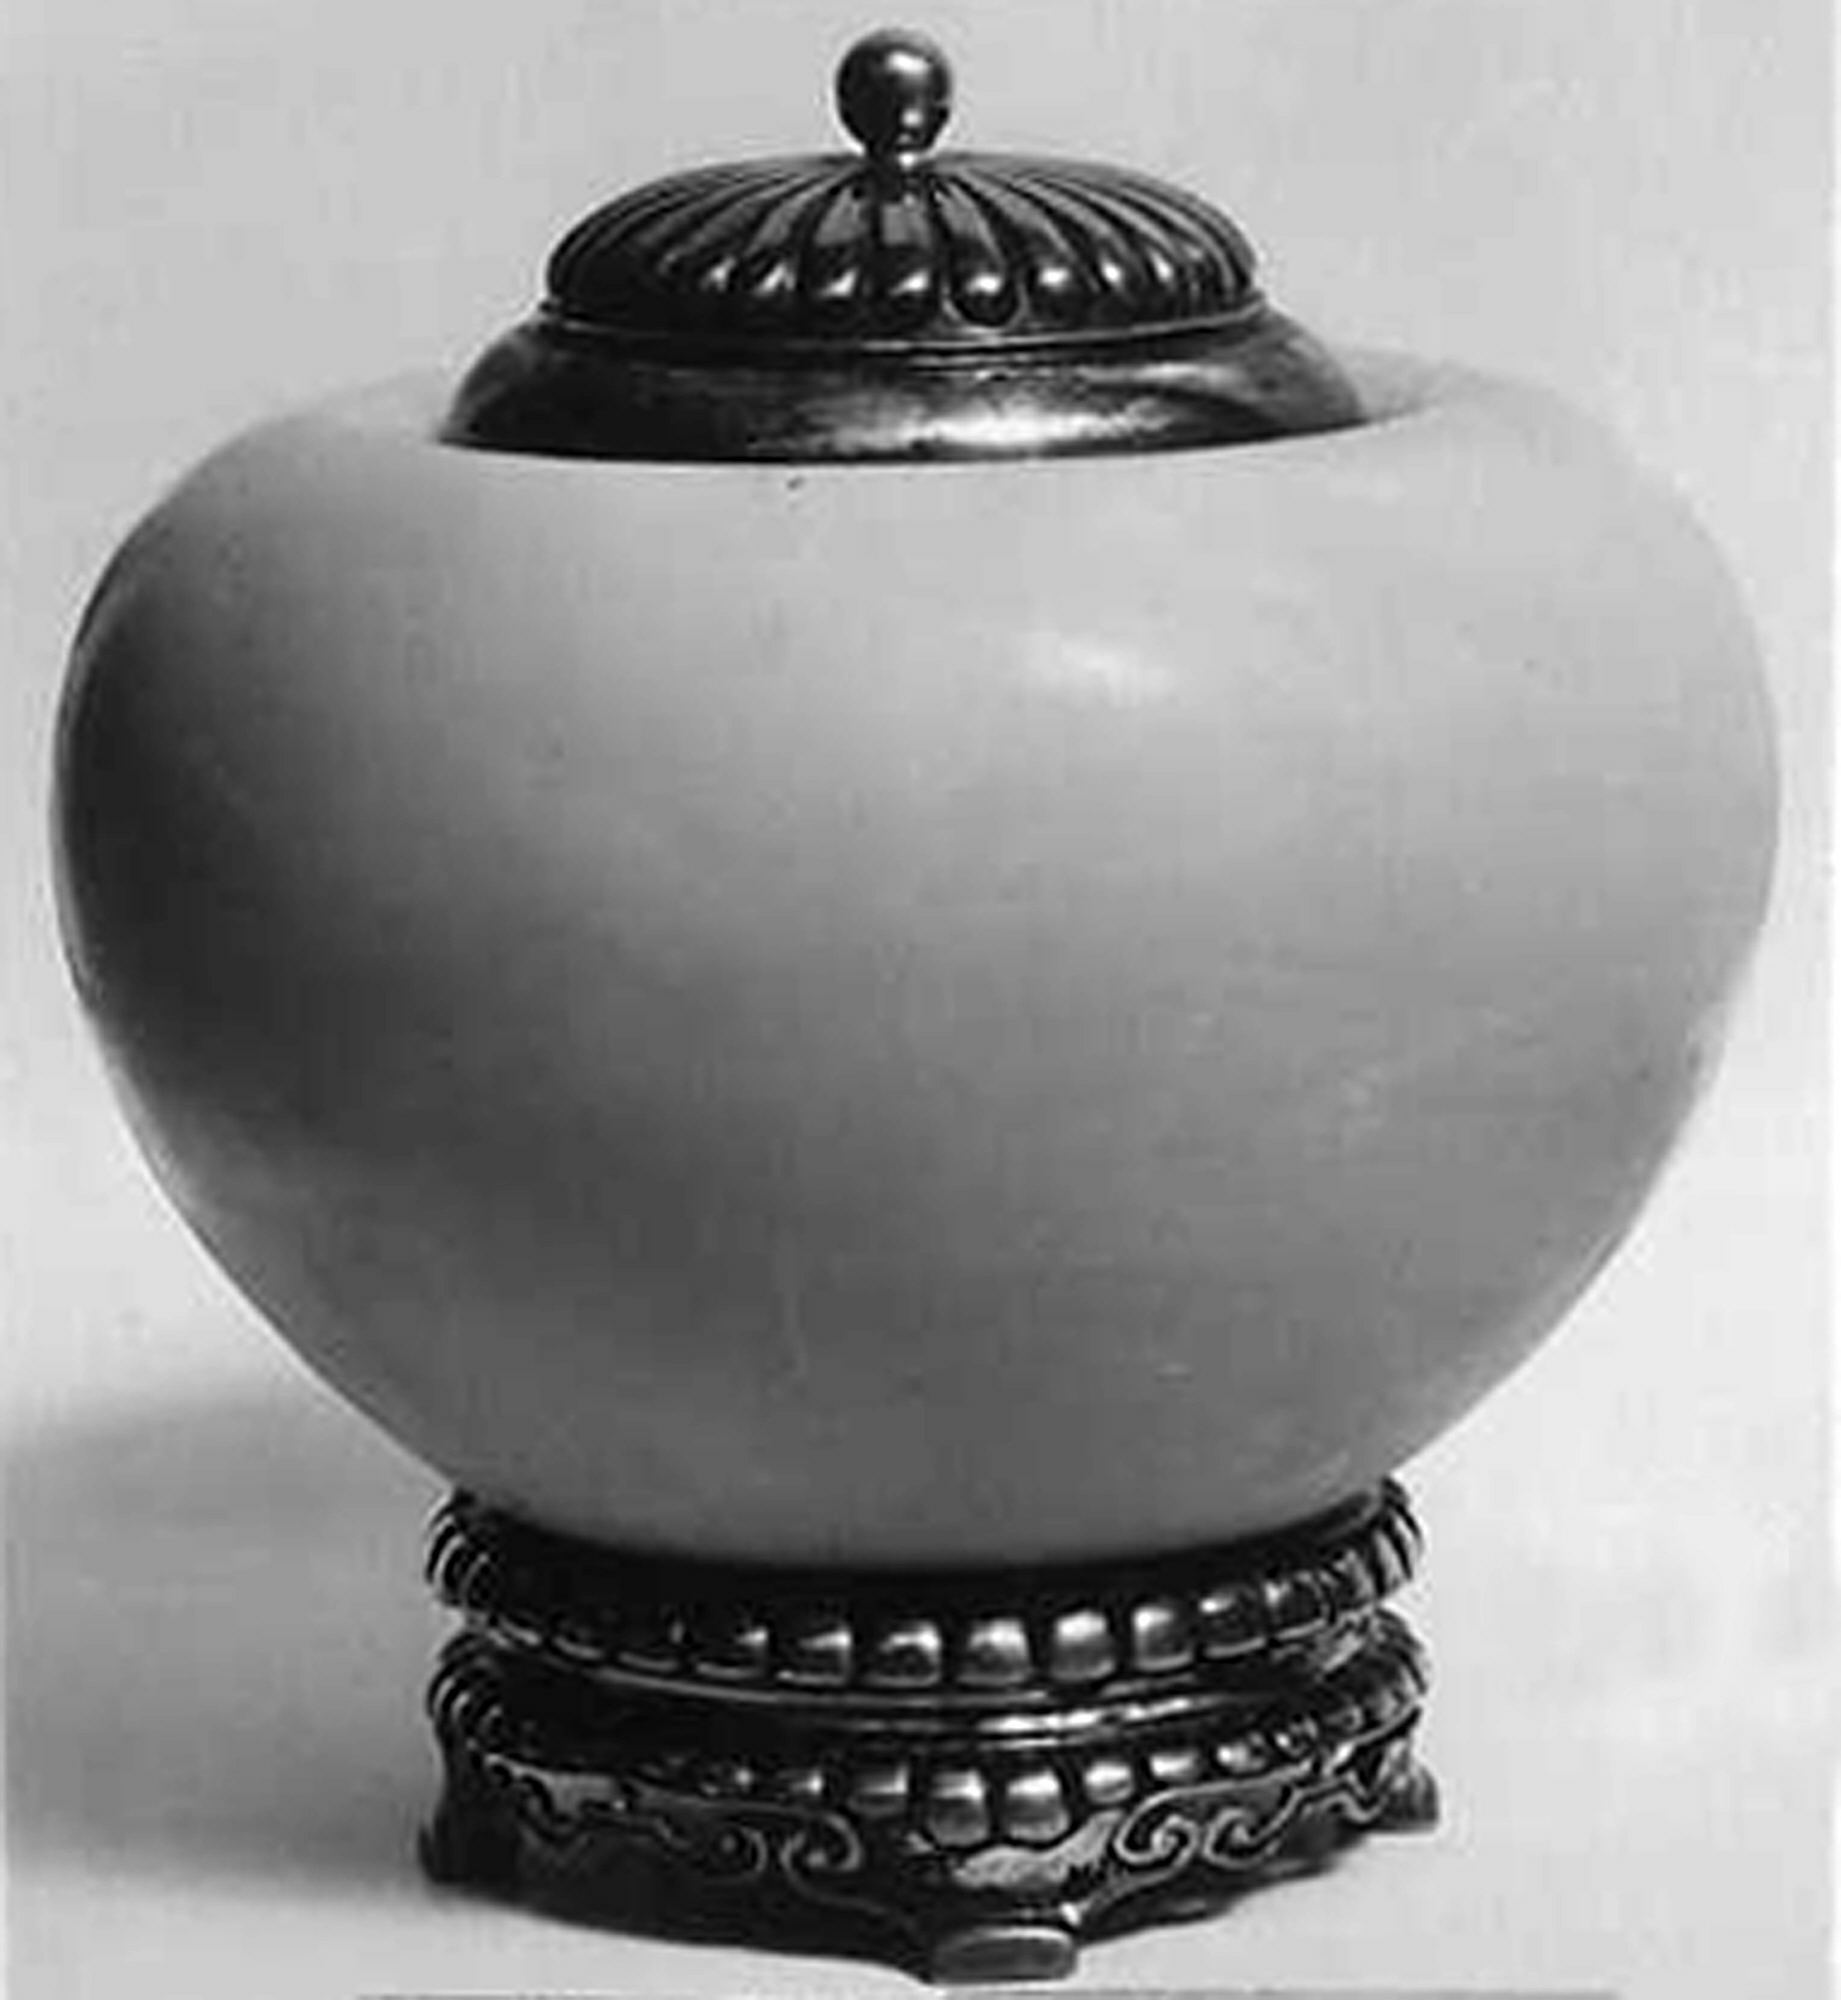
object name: water coupe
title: Water Coupe (one of a pair)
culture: chinese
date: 1662-1722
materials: glaze, porcelain